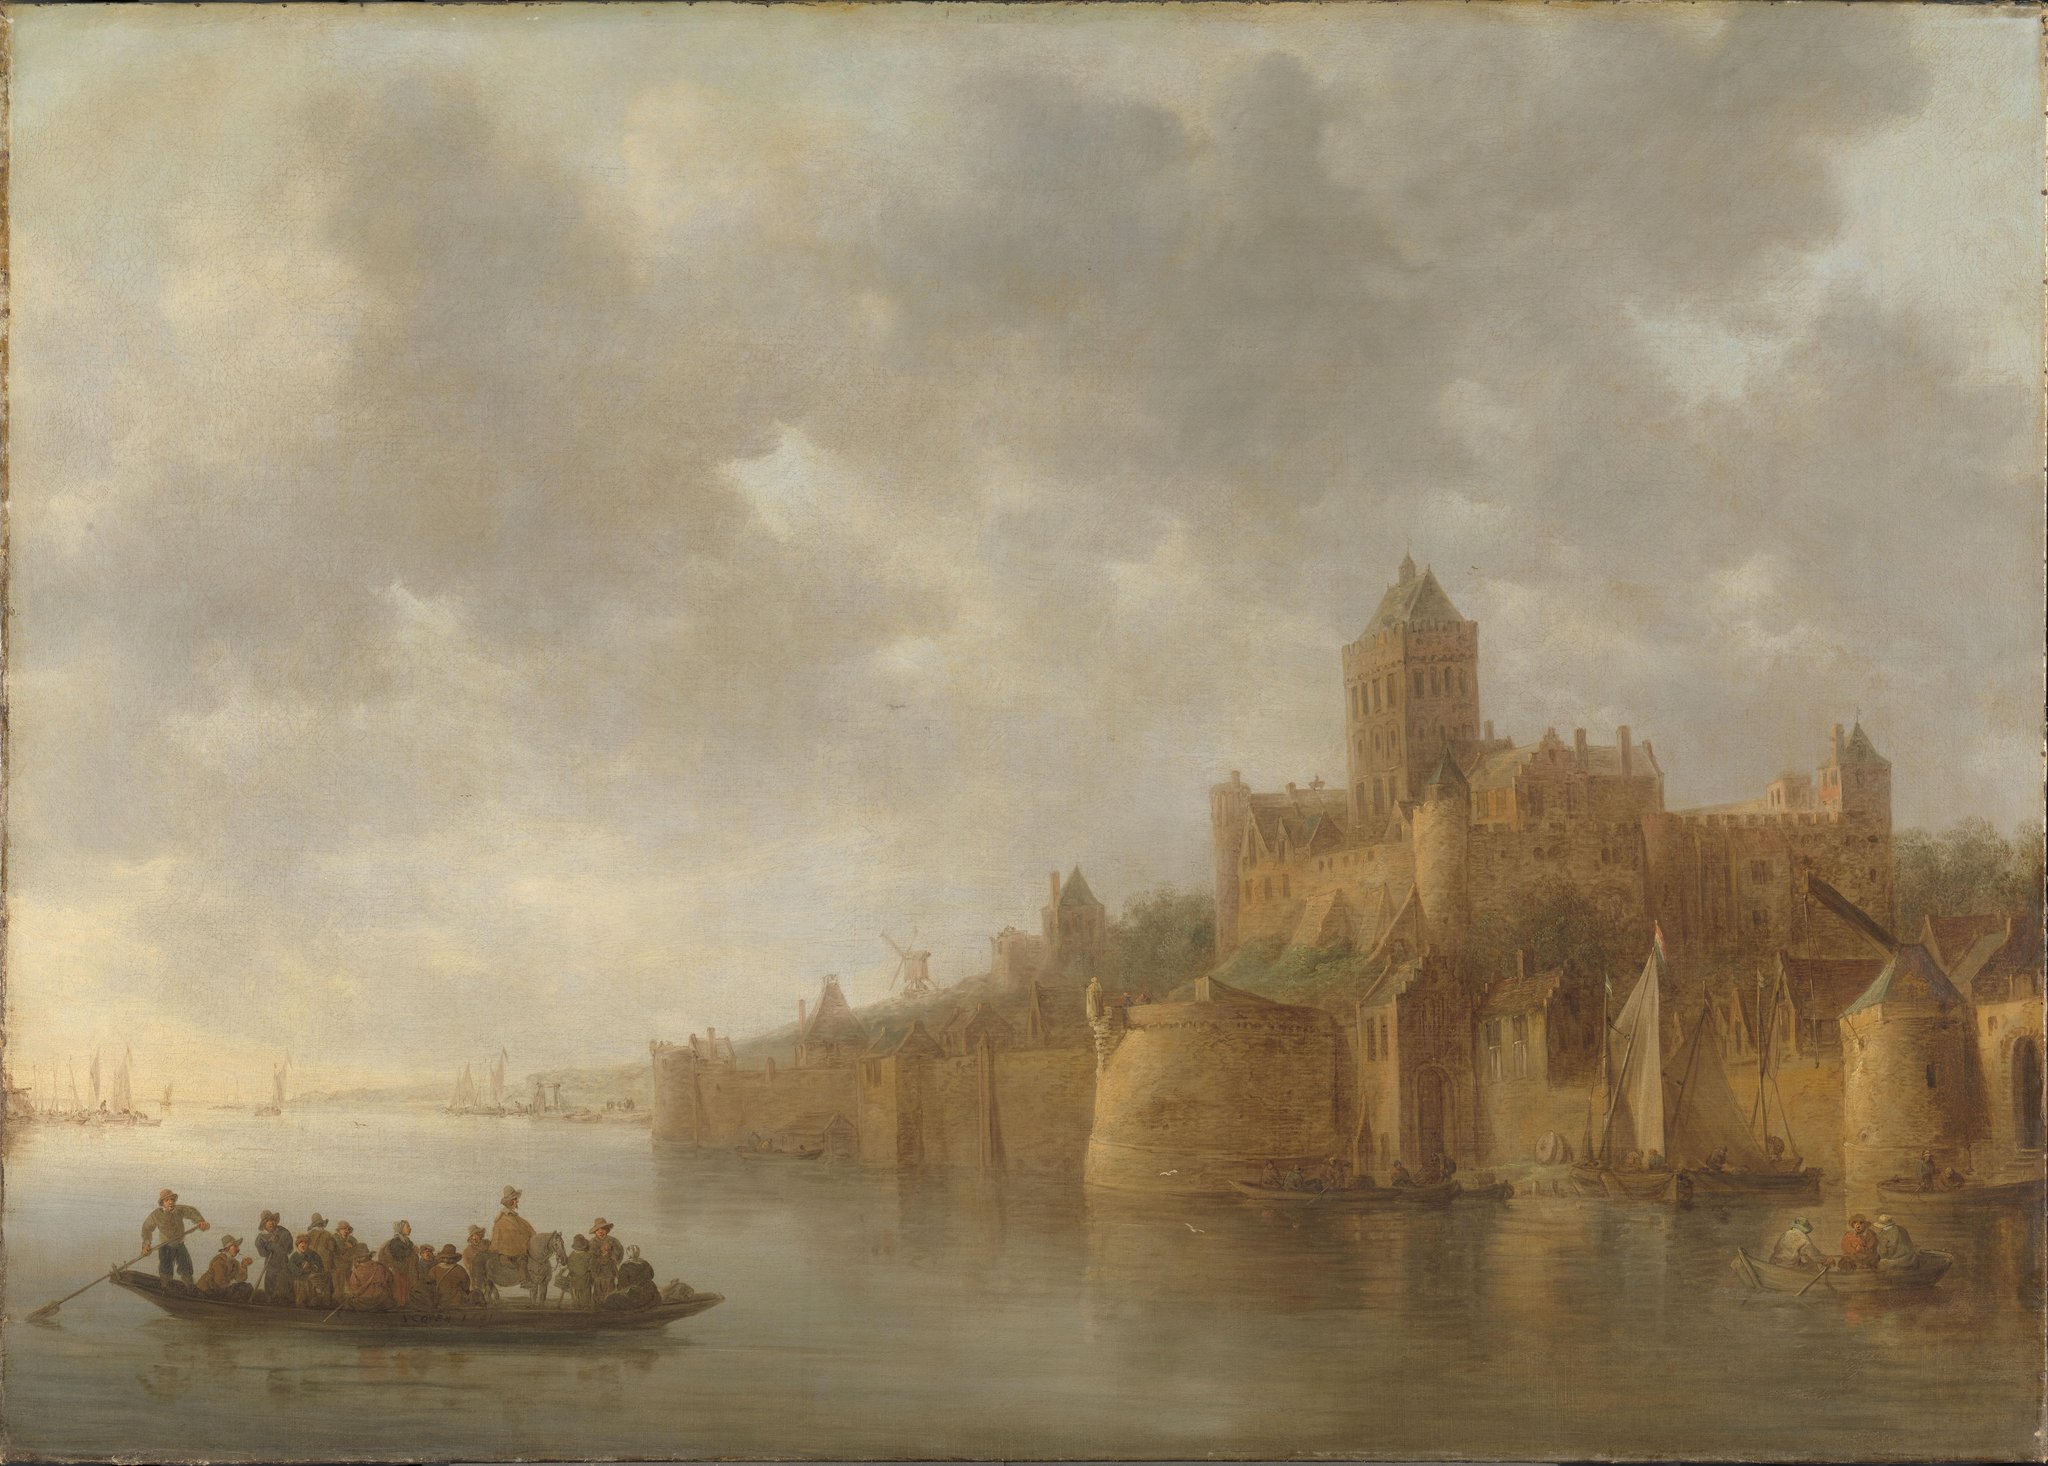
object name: painting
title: The Valkhof in Nijmegen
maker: jan van goyen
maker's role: draughtsman, painter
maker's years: 1596-1656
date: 1641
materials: canvas, oil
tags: river, ferry, poling, punting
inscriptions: signature and date, lower left, on the ferry boat: ‘V Goyen 1641’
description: Gezicht op het Valkhof, gelegen bij de Waal te Nijmegen. Op de voorgrond steekt een veerpont de rivier over.